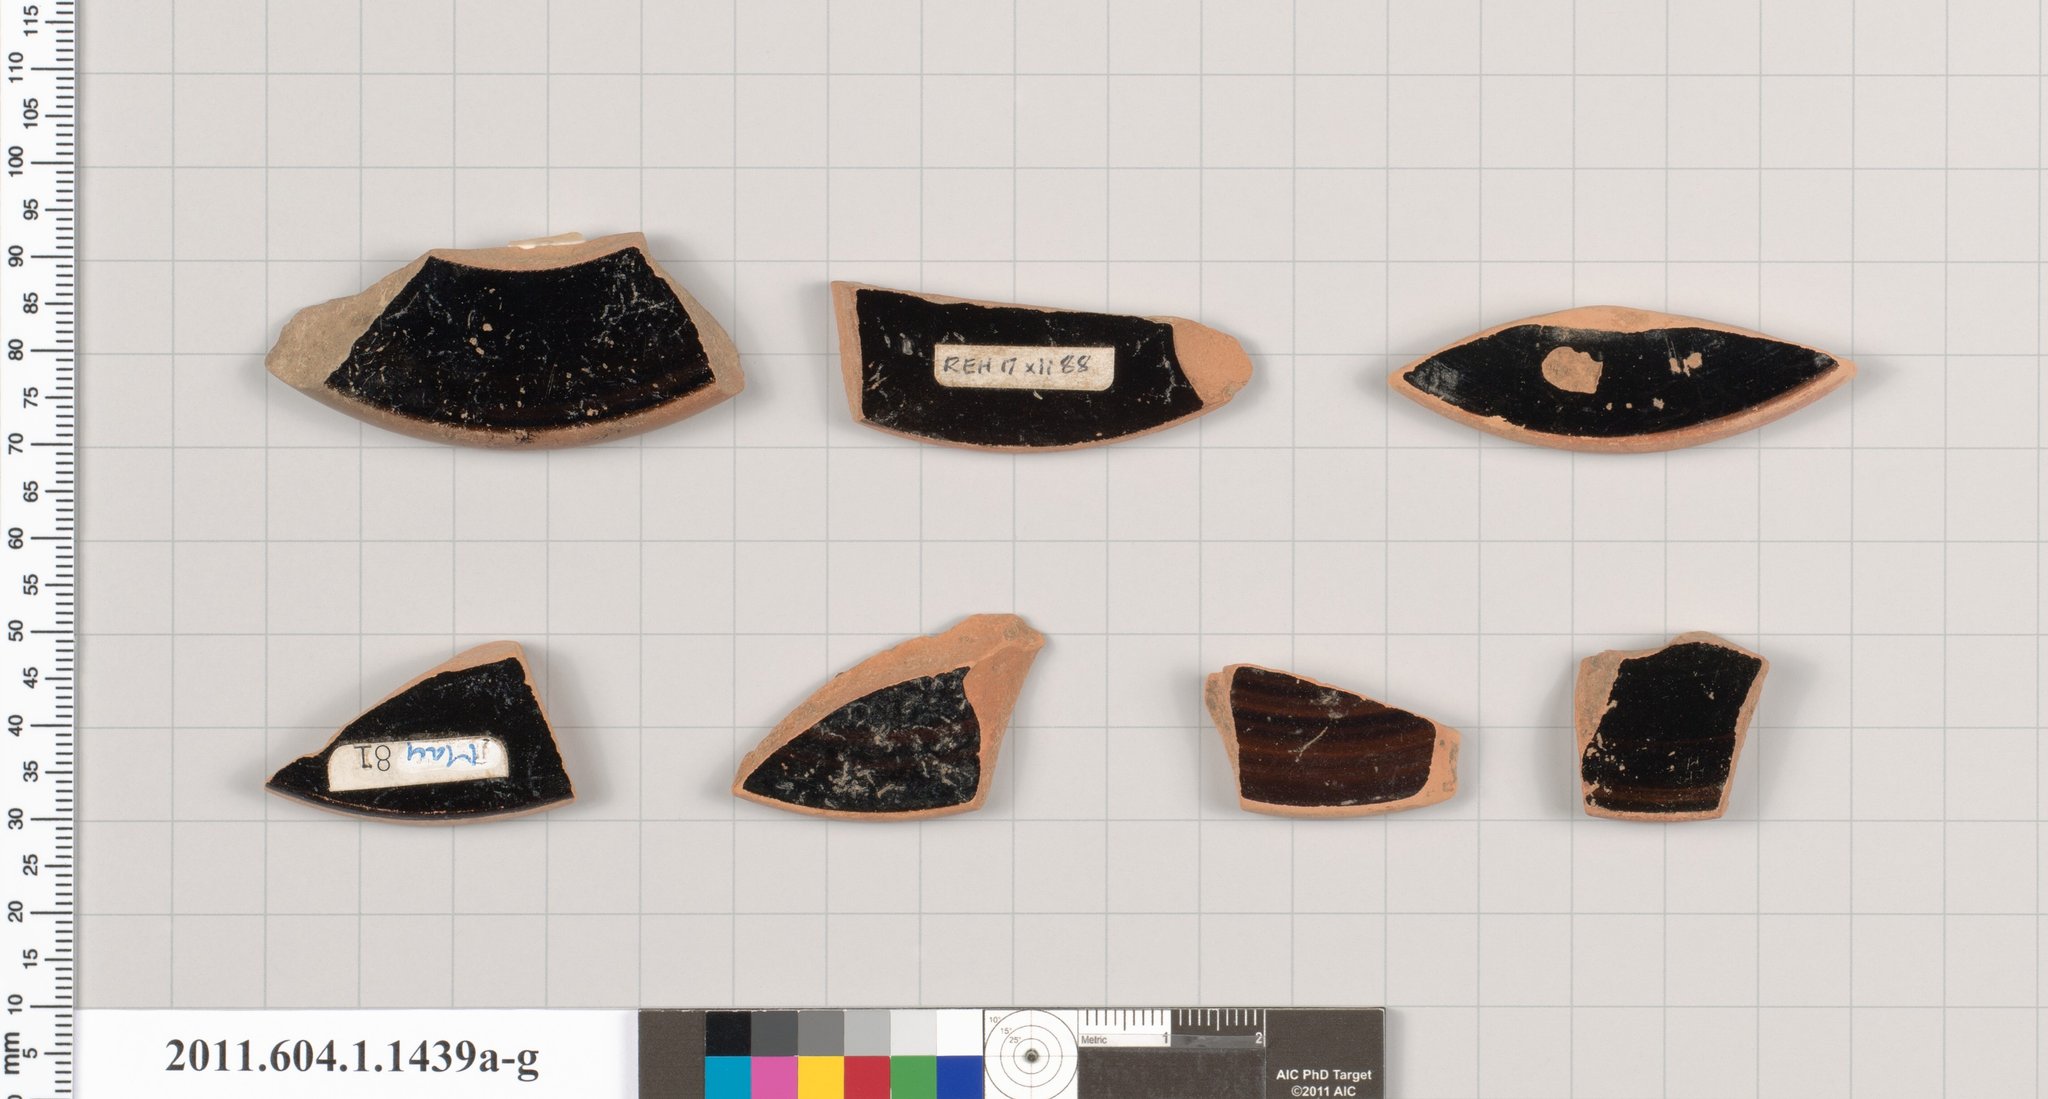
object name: kylix fragment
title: Terracotta fragments of kylikes (drinking cups)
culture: greek, attic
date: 500-401 BCE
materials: terracotta